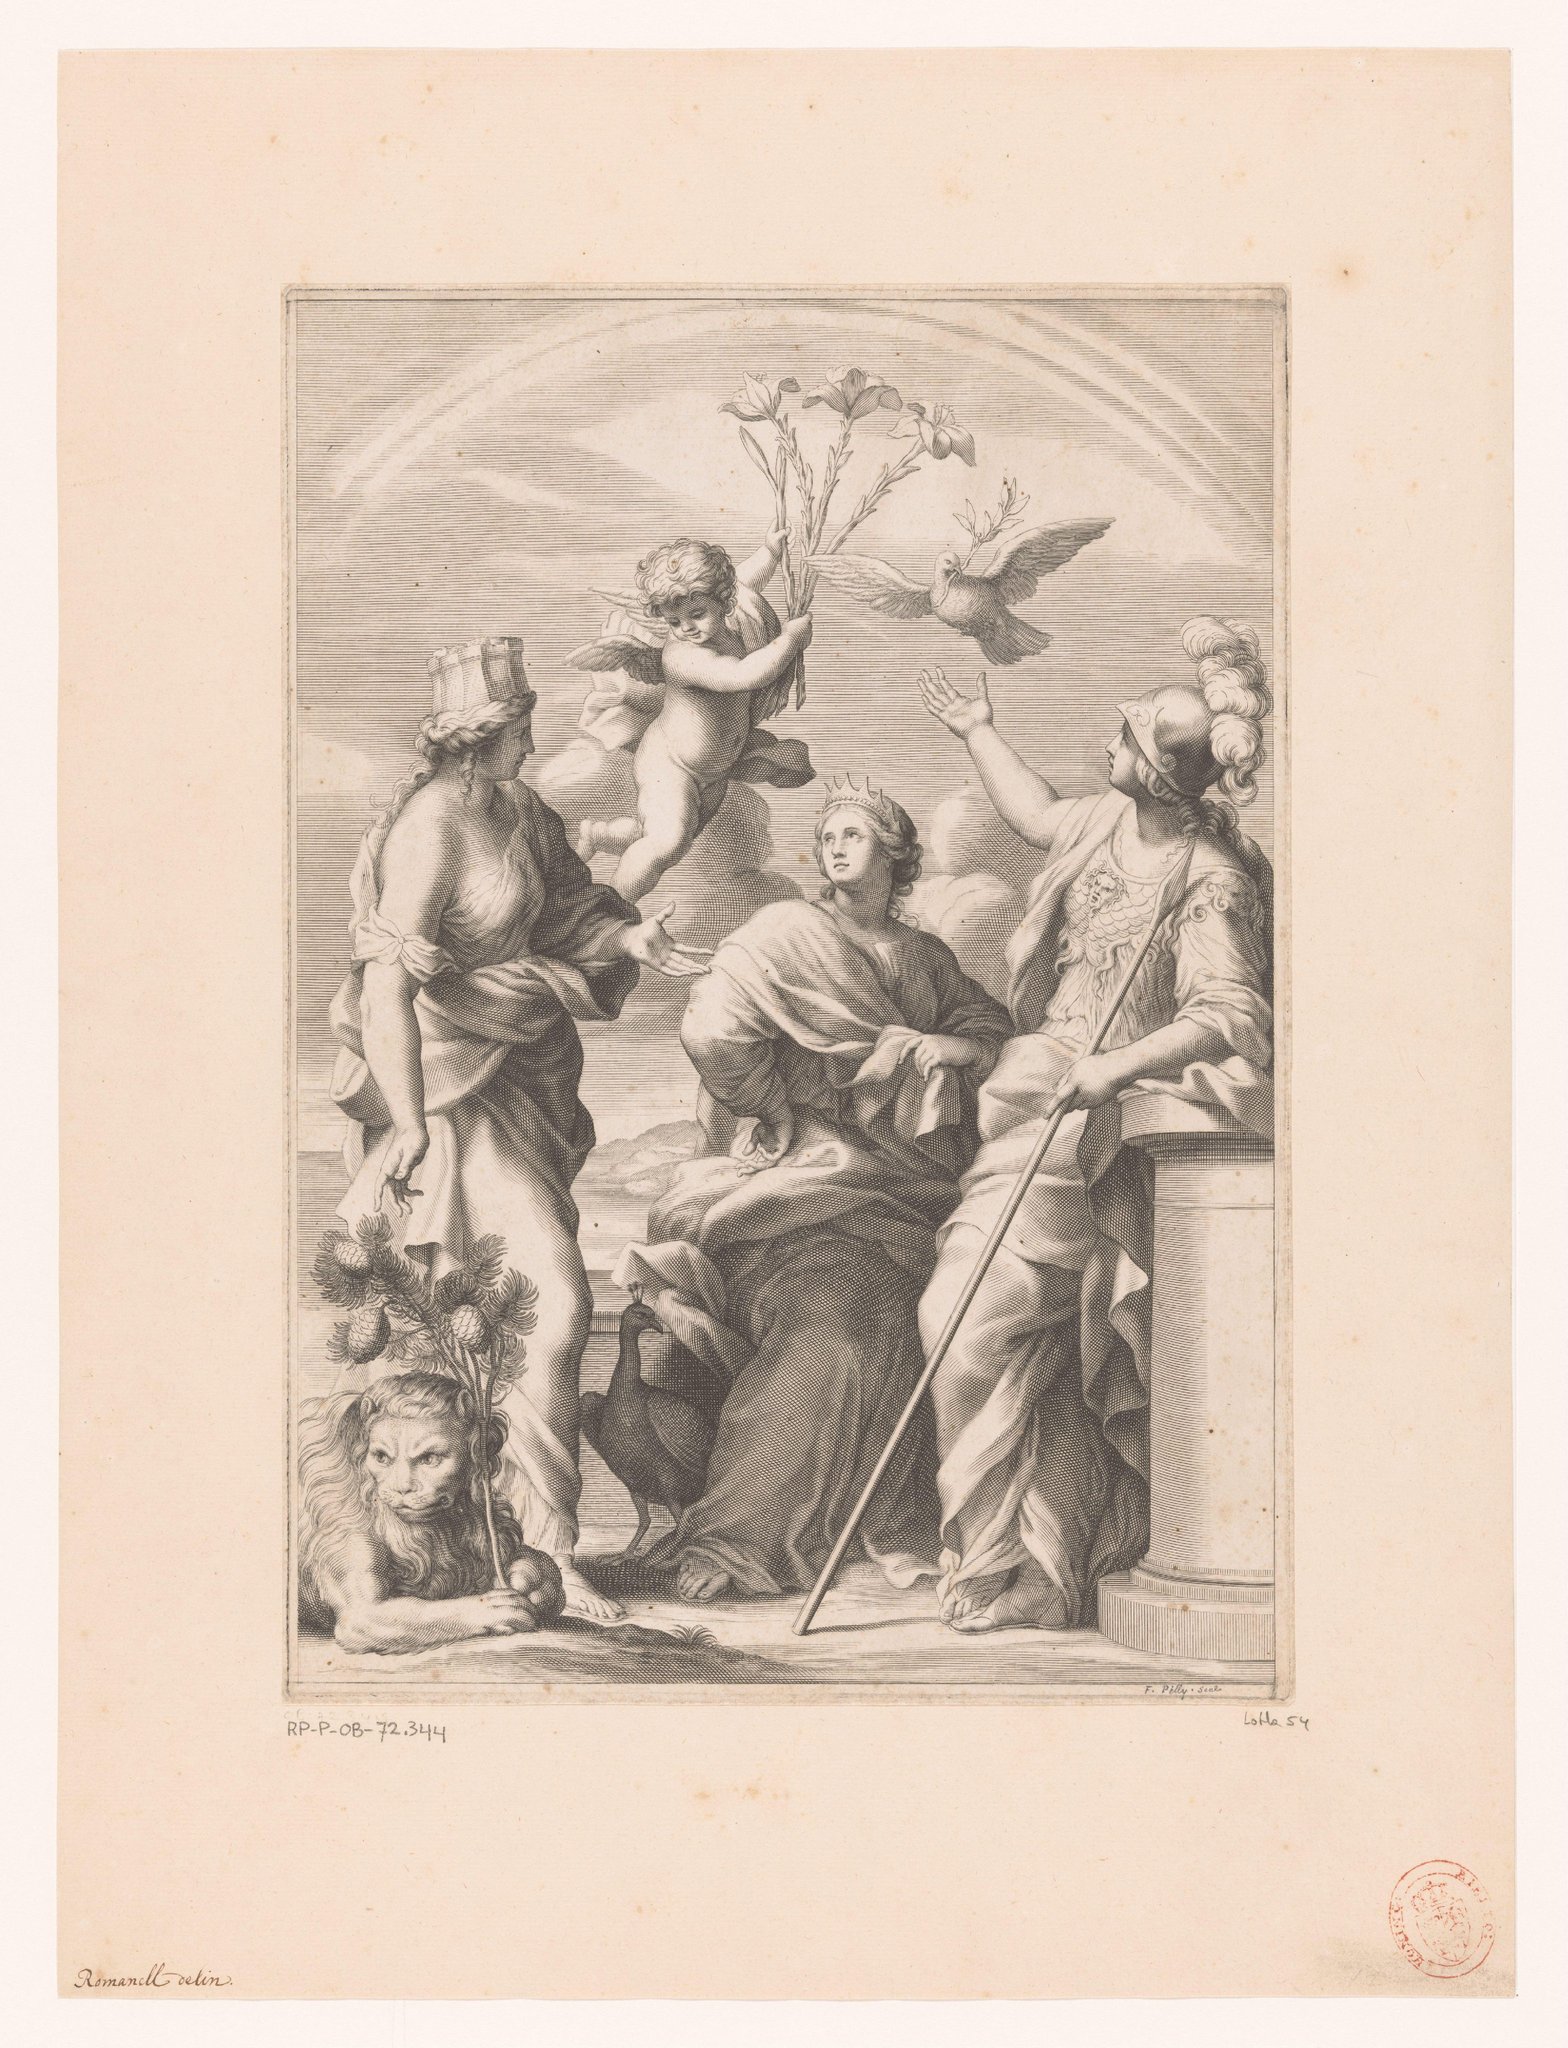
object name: print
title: Cybele, Juno en Minerva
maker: françois de poilly (i)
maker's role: print maker, publisher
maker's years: 1622-1693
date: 1632-1693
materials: paper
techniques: engraving, etching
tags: (story of) juno (hera), (story of) minerva (pallas, athena), specific aspects, allegorical aspects of cybele; cybele as patroness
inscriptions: collector's mark: Lugt 240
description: Drie vrouwen bij elkaar, boven hen een putto met lelies en een vredesduif. Bij Cybele een leeuw met dennentak, bij Juno een pauw.